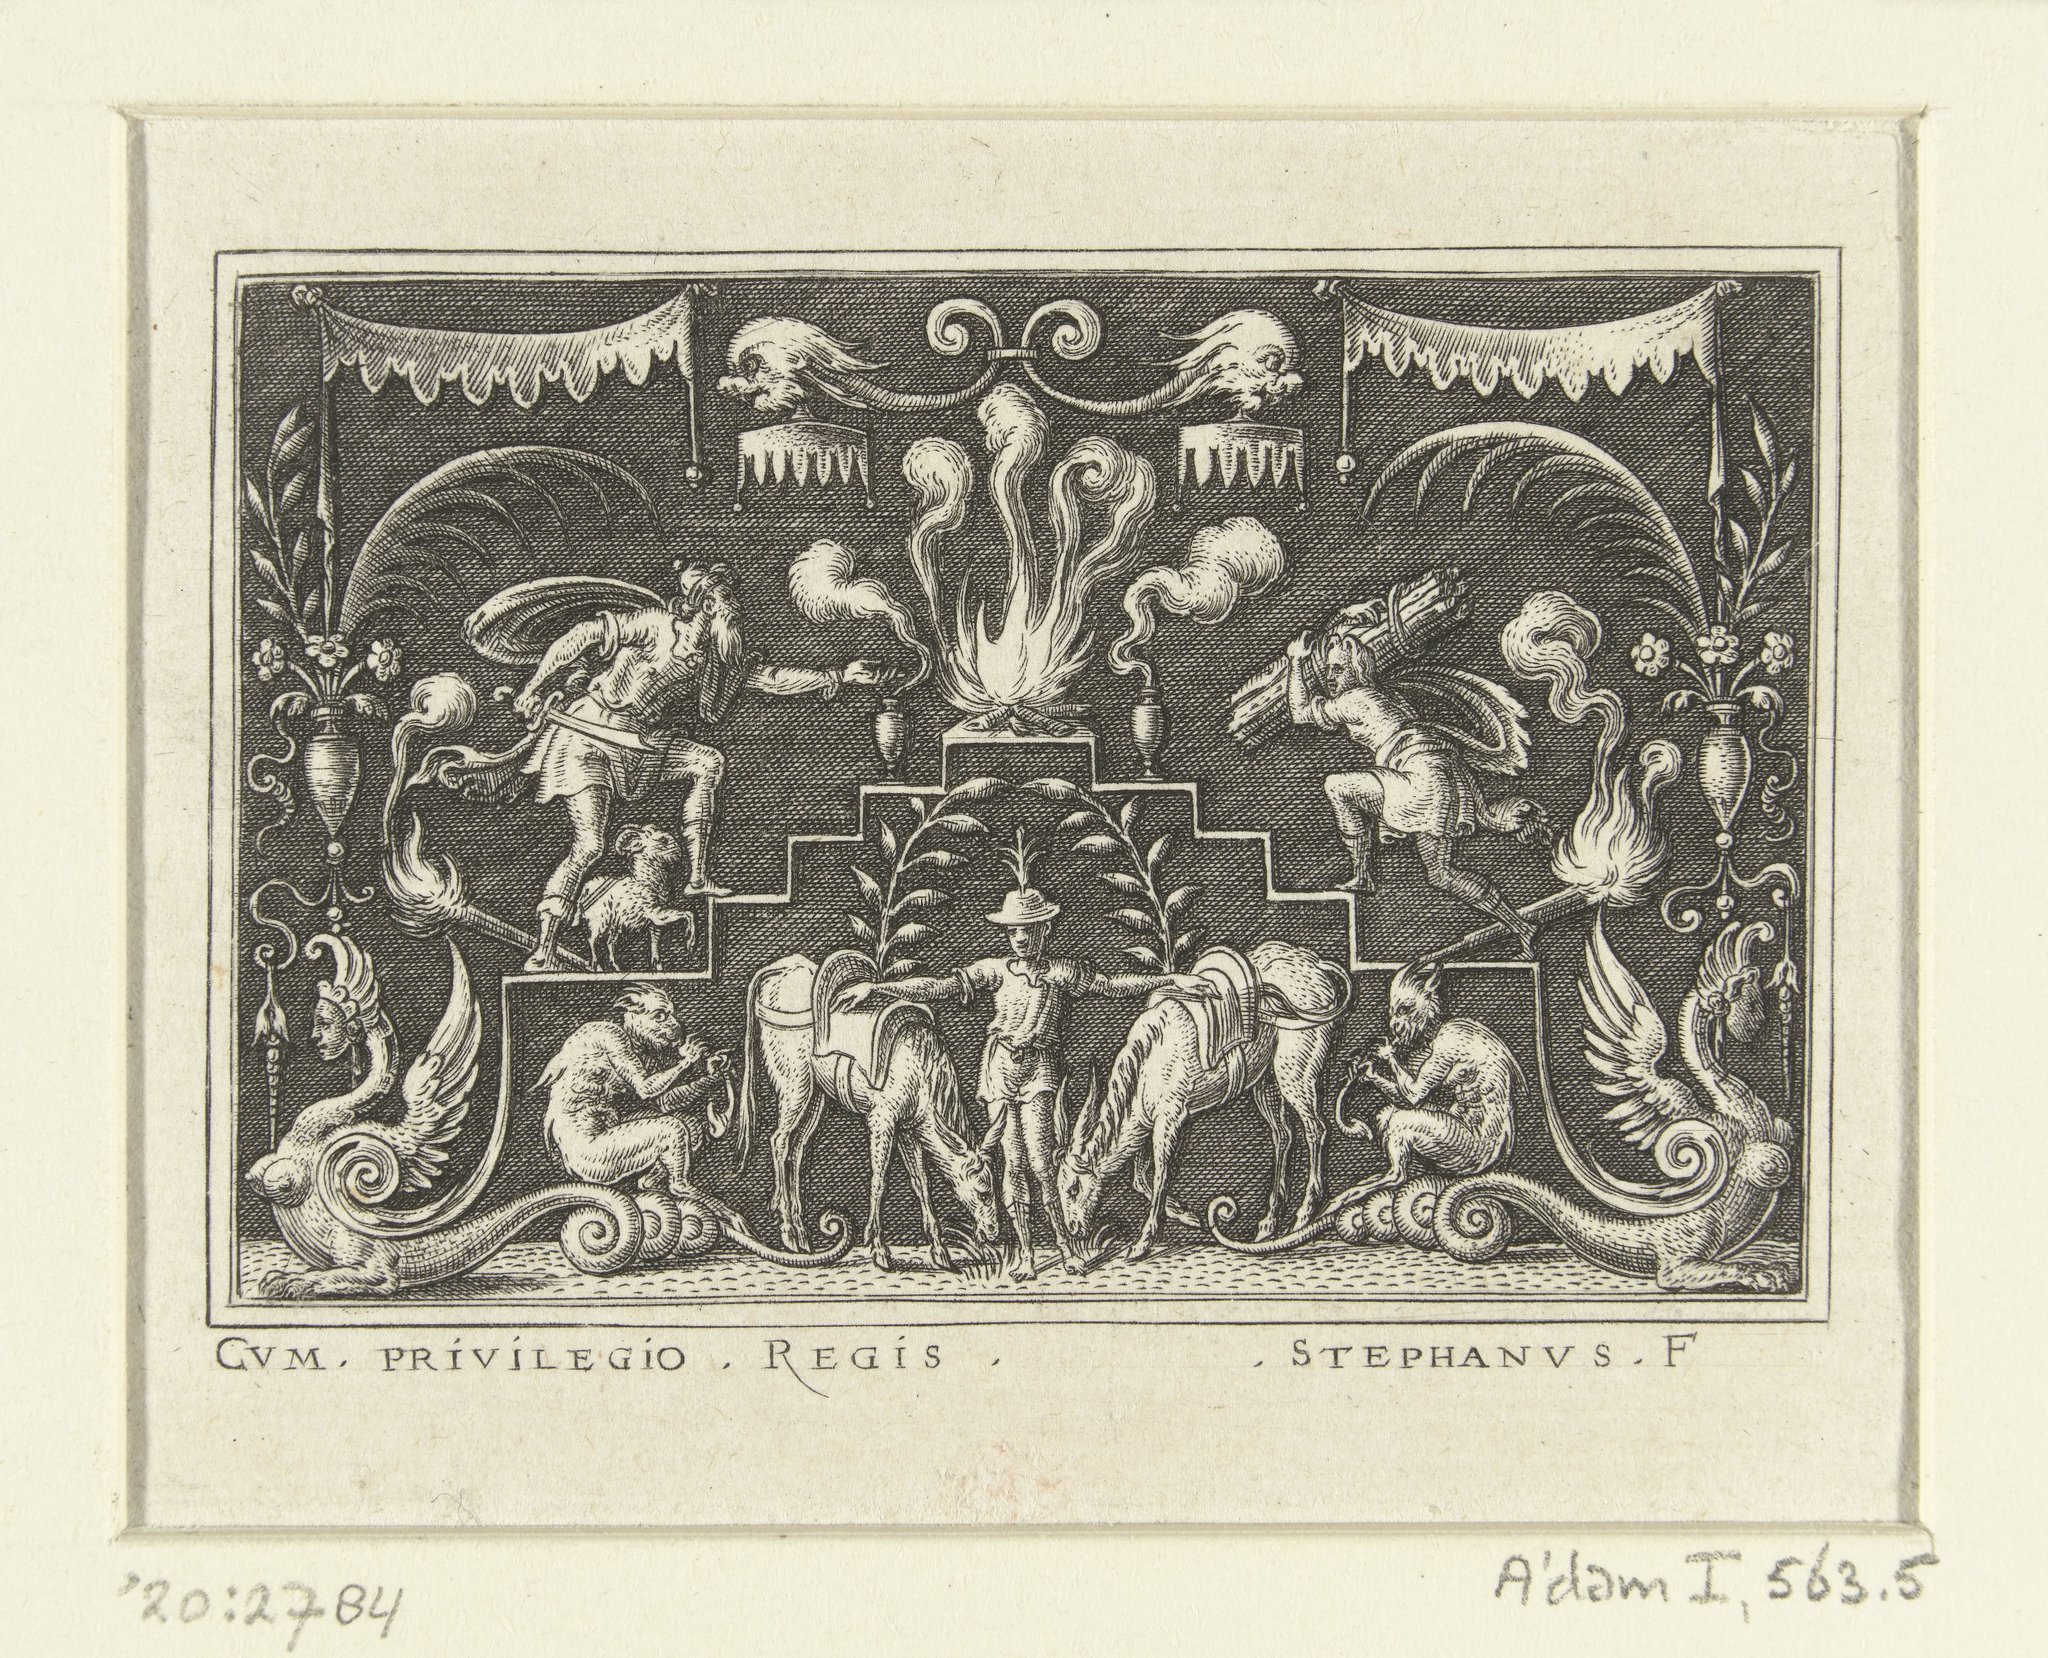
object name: ornament print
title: Vlakdecoraties met scènes uit het Oude Testament in een omlijsting van grotesken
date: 1528-1583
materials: paper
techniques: engraving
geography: france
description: In het midden brandt een vuur op het altaar waar treden naartoe wijzen. Uit serie van 6 bladen.